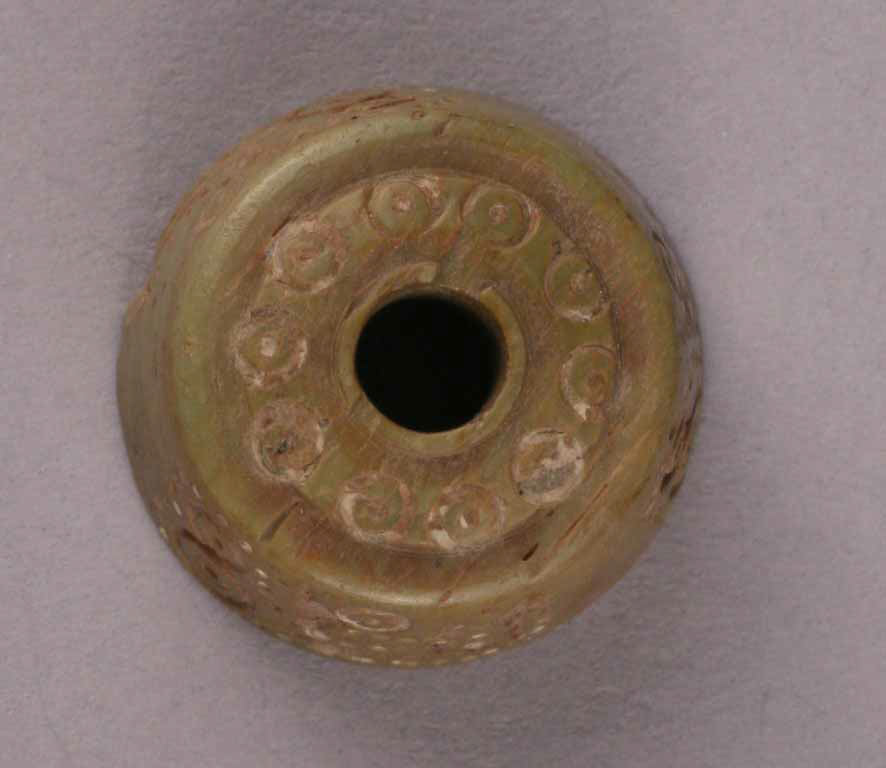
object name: button or bead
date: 801-1000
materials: bone, paint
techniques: incising, inlay, tinting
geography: iran